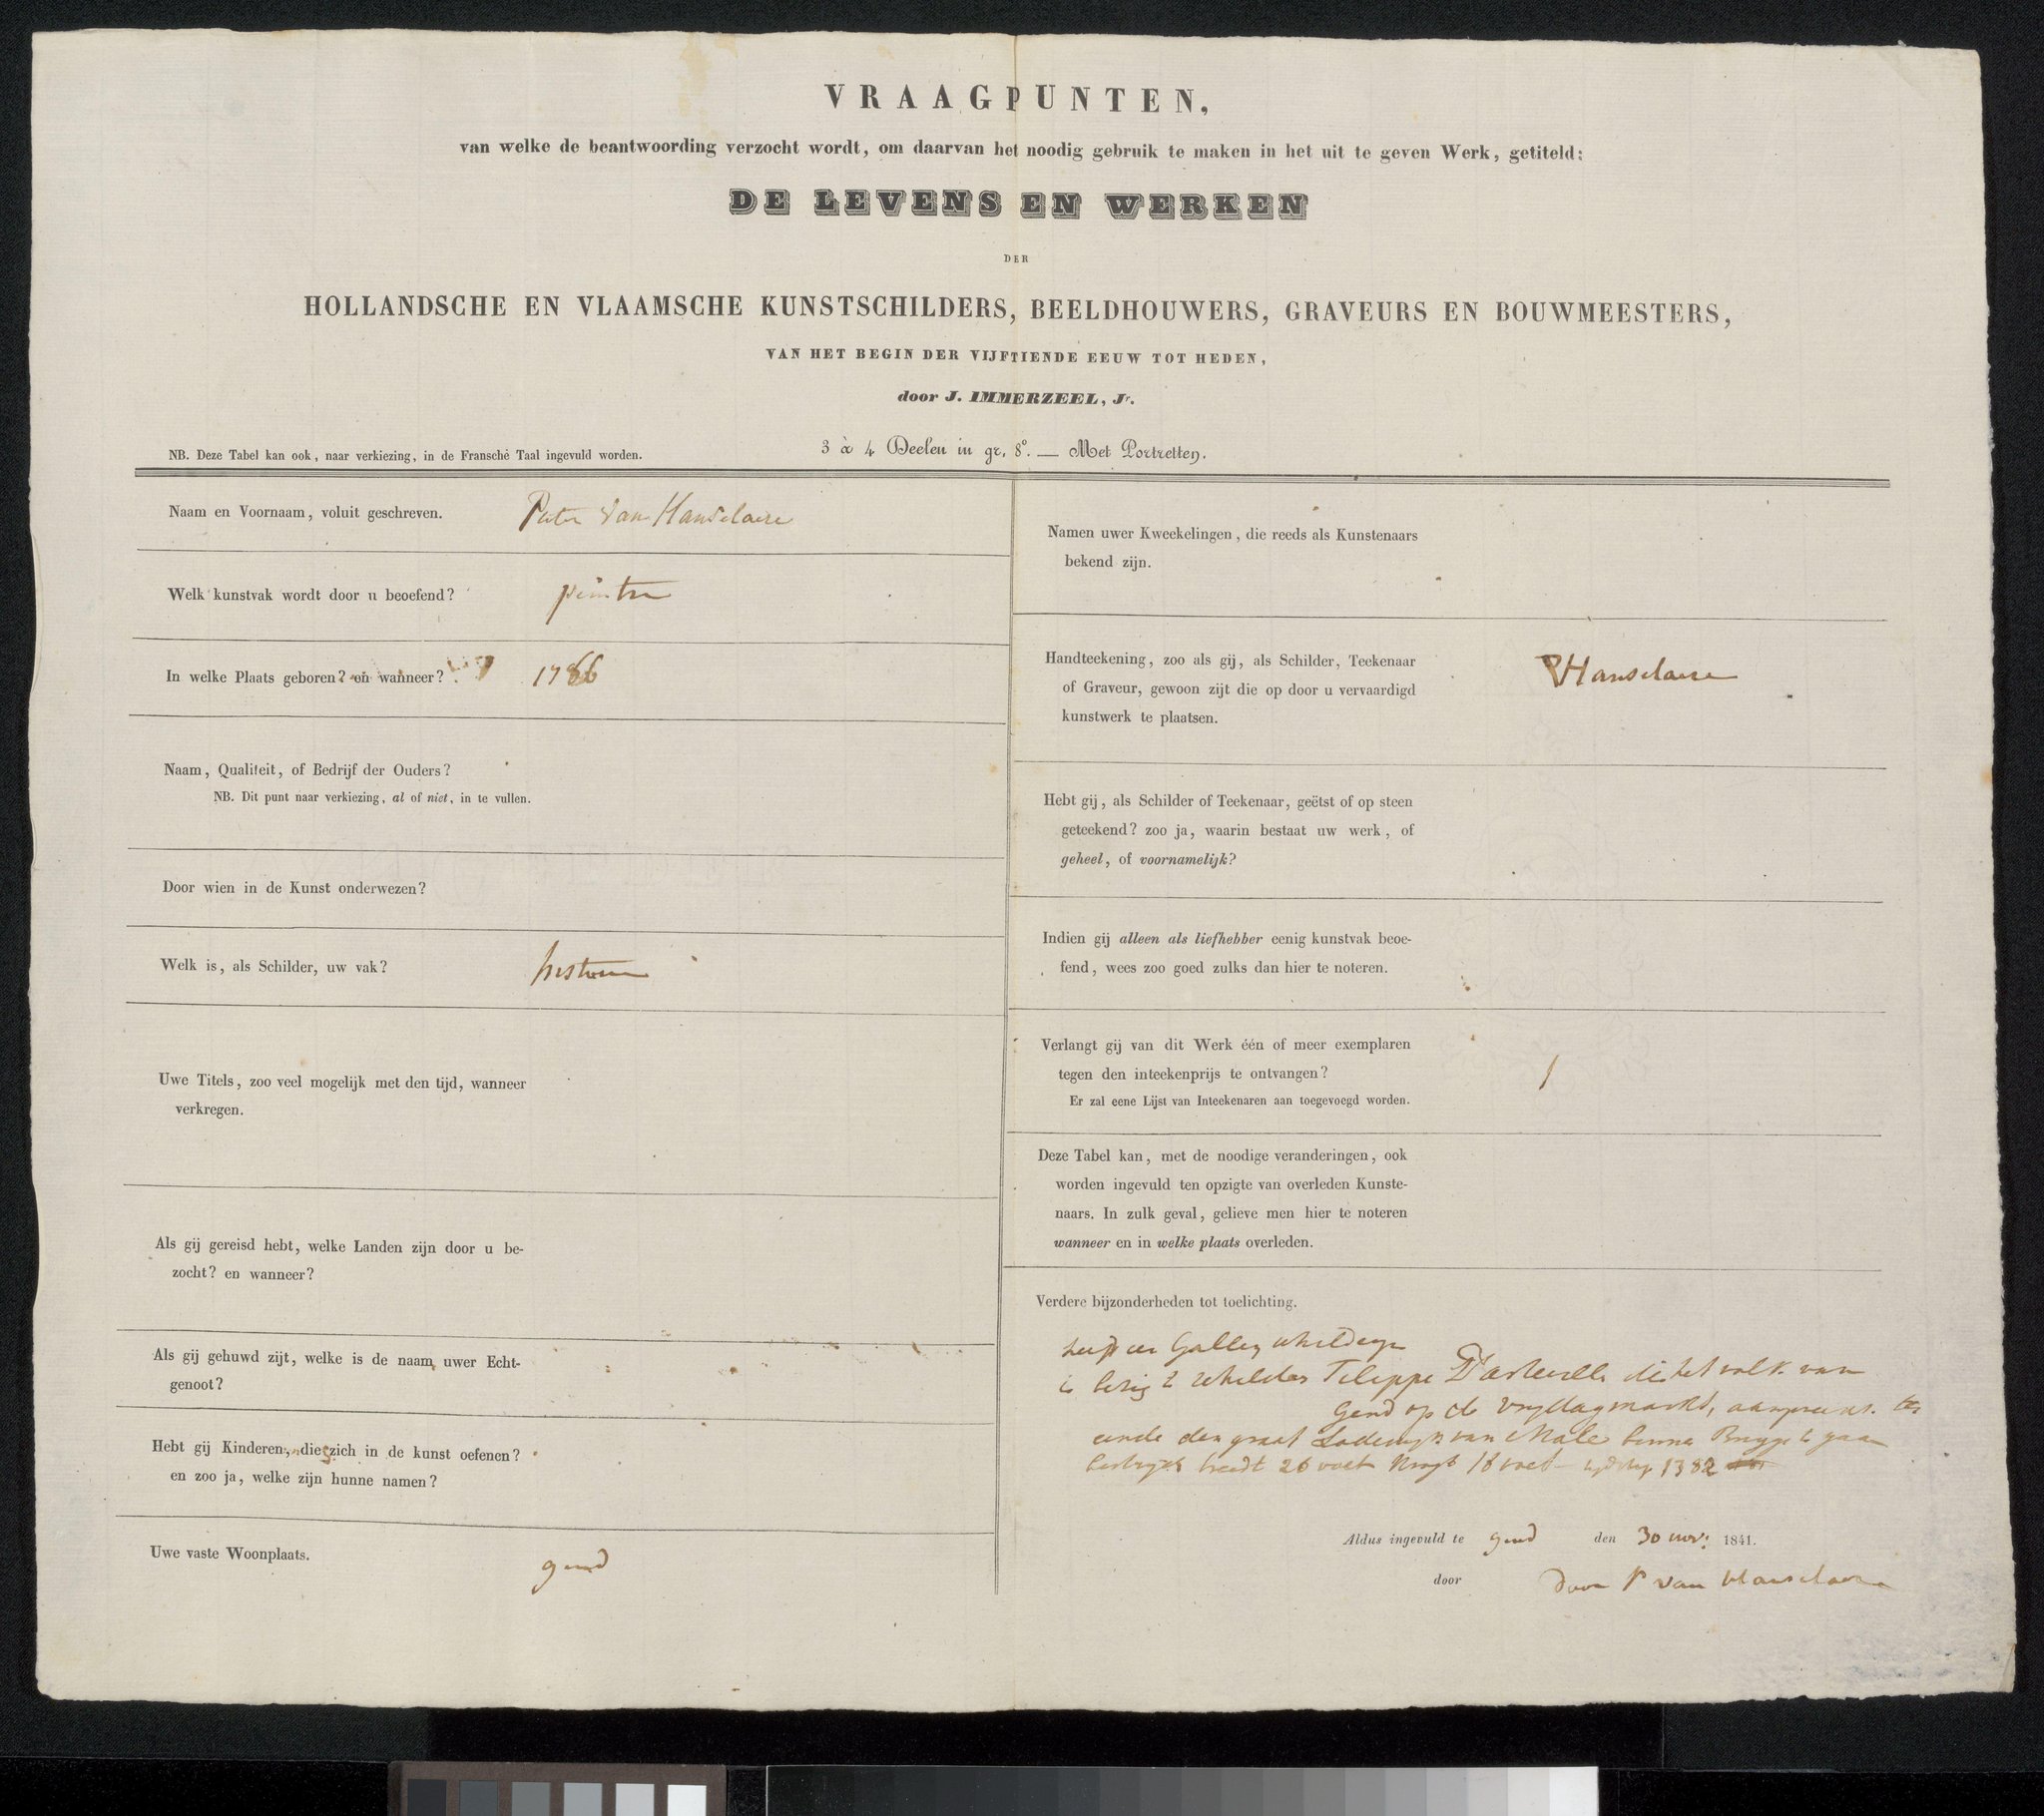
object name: manuscript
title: Enquêteformulier ingevuld door Pierre Van Hanselaere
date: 1841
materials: ink, paper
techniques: pen, printing, writing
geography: ghent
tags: ghent, pierre van hanselaere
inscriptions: inscription: ‘Vraagpunten,/ van welke de beantwoording verzocht wordt, om daarvan het noodig gebruik te maken in het uit te geven Werk, getiteld: De levens en werken/ der Hollandsche en Vlaamsche kunstschilders, beeldhouwers,/ graveurs en bouwmeesters, van het begin der vijftiende eeuw tot heden/ door J. Immerzeel, Jr.’, watermark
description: Opgenomen in: Immerzeel, J. Jr., De levens en werken der Hollandsche en Vlaamsche kunstschilders, beeldhouwers, graveurs en bouwmeesters, van het begin der vijftiende eeuw tot heden, Amsterdam: J.C. van Kesteren, 1842-1843.